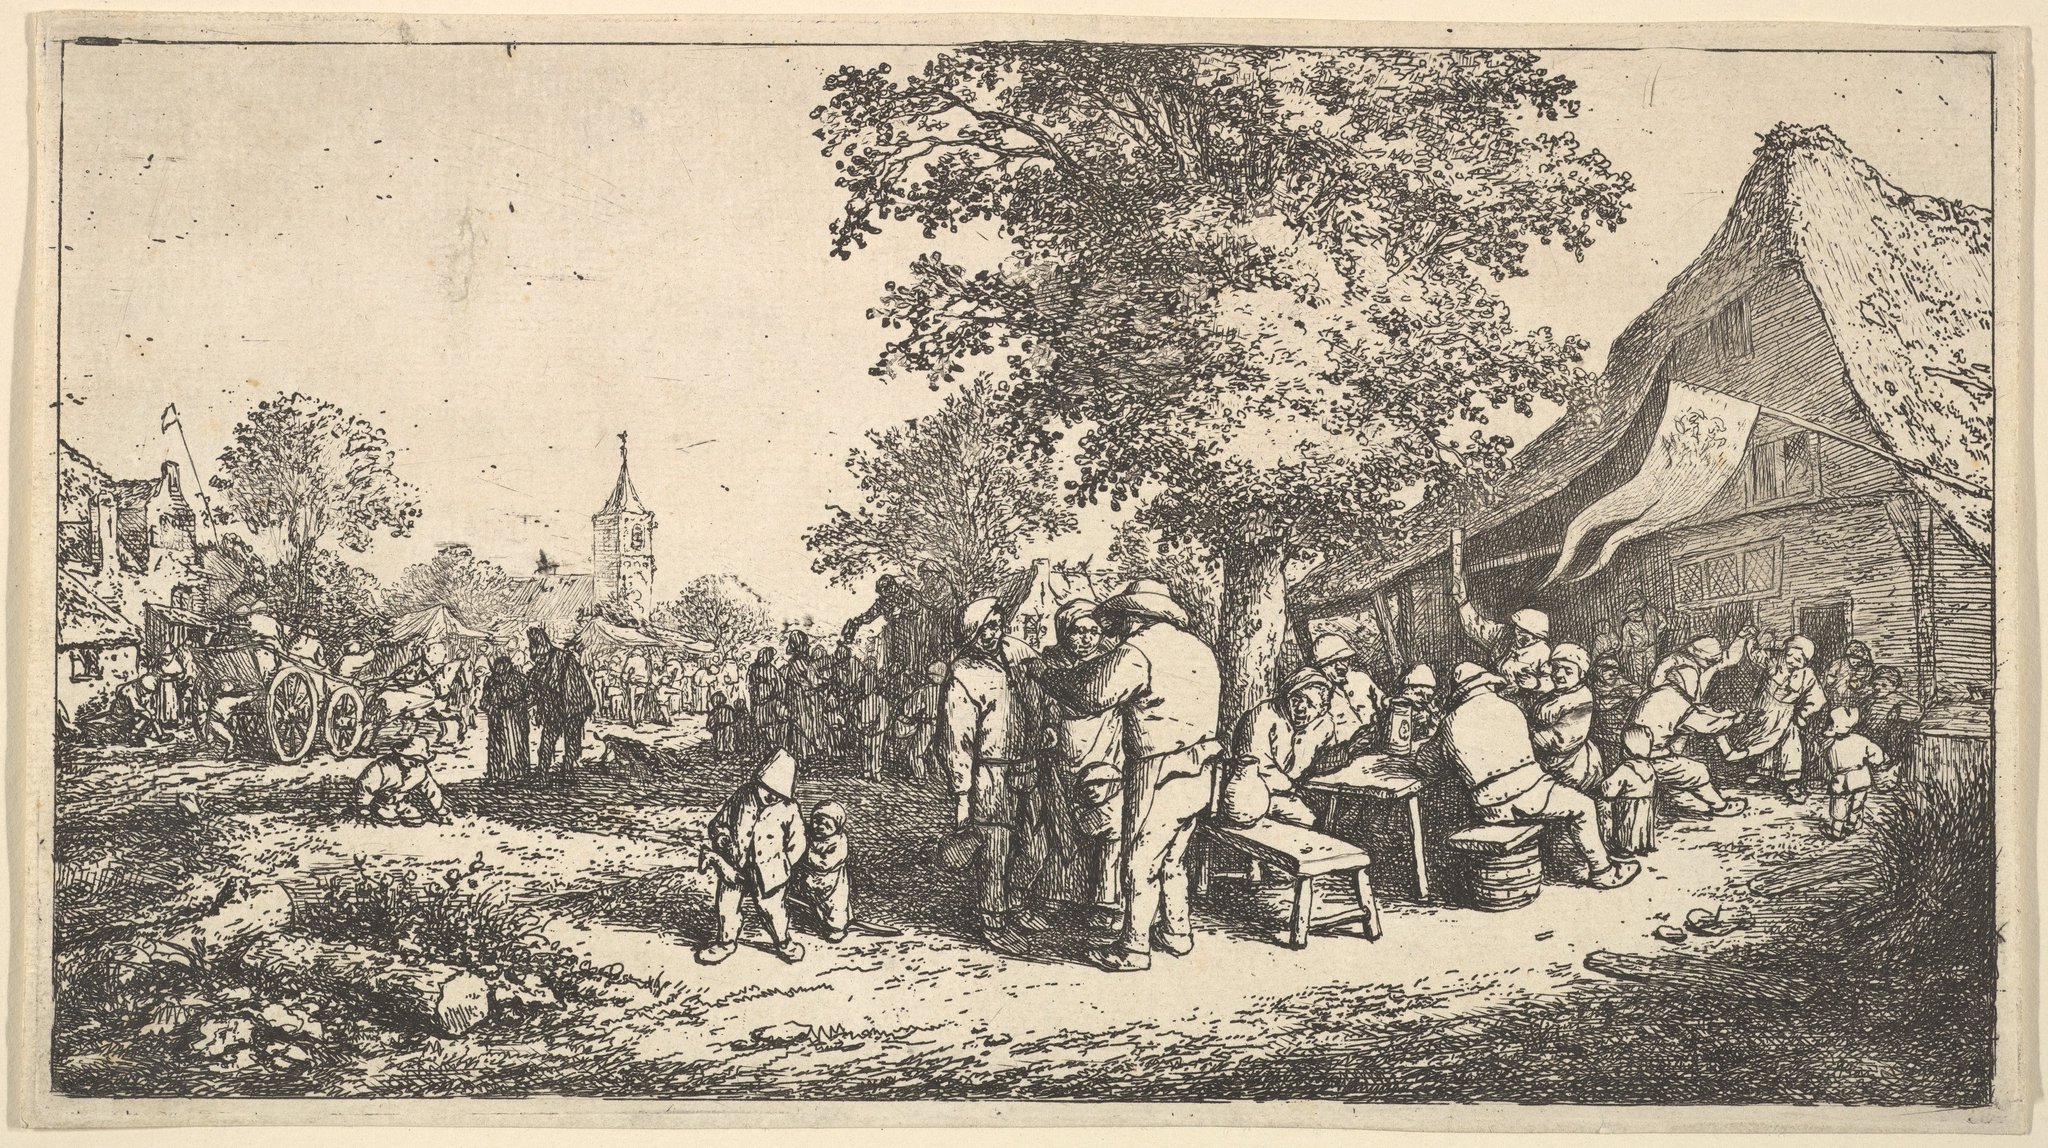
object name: print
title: The Kermess Under the Great Tree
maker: adriaen van ostade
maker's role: artist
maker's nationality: dutch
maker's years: 1610-1685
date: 1610-1685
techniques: etching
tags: human figures,entertainment,trees